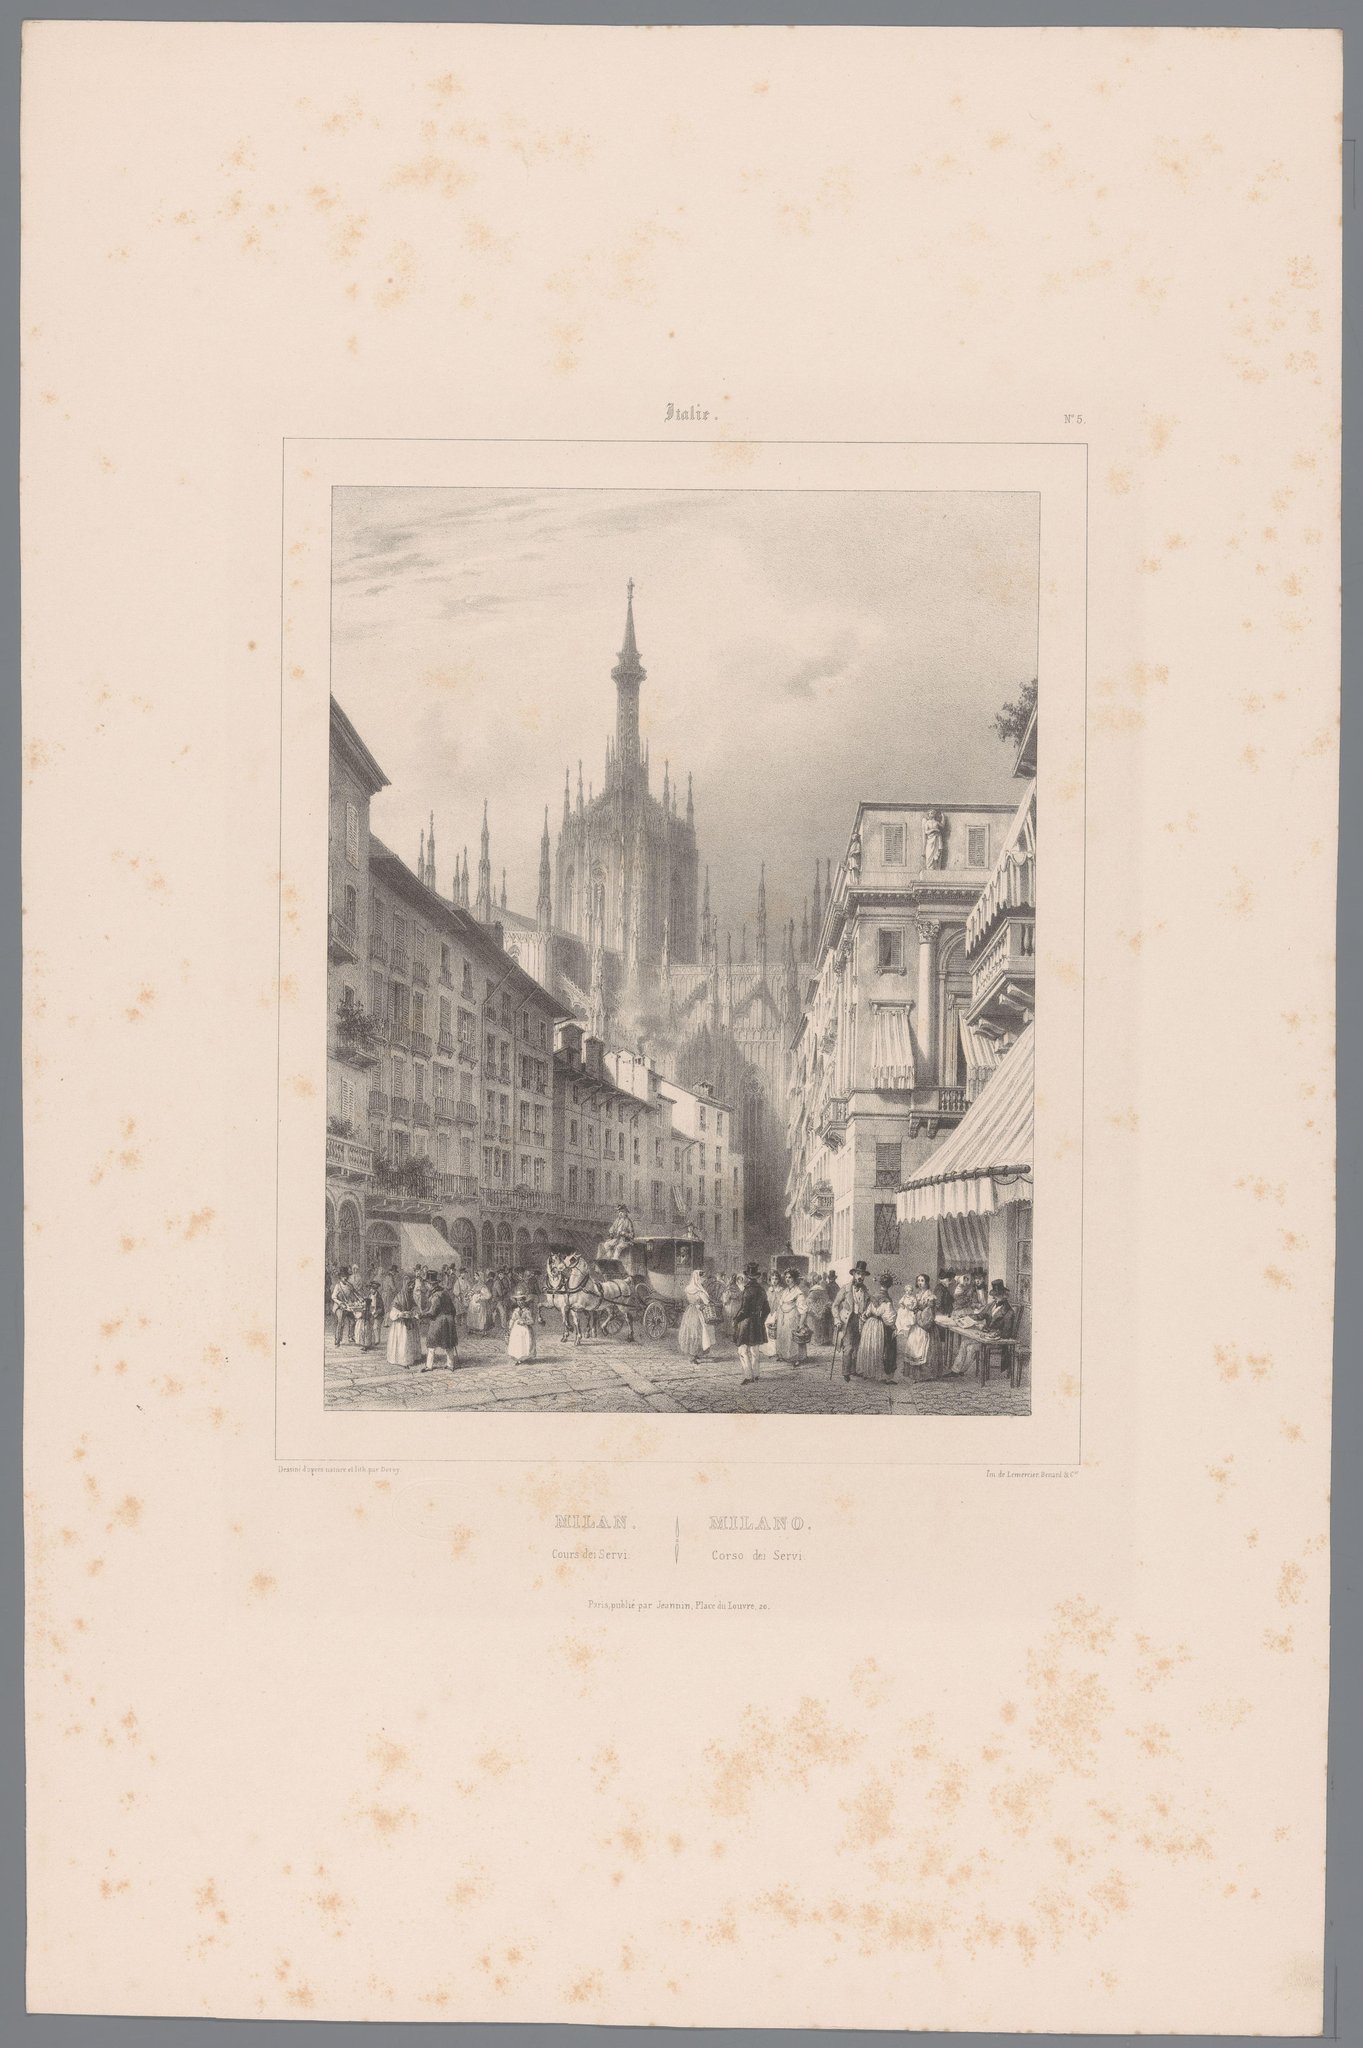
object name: print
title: Gezichten in Milaan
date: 1838-1841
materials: paper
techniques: lithograph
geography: paris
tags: church (exterior), street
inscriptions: check stamp: Lugt 1397c, collector's mark: Lugt 2228a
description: Prent maakt deel uit van een omslag met zes prenten.